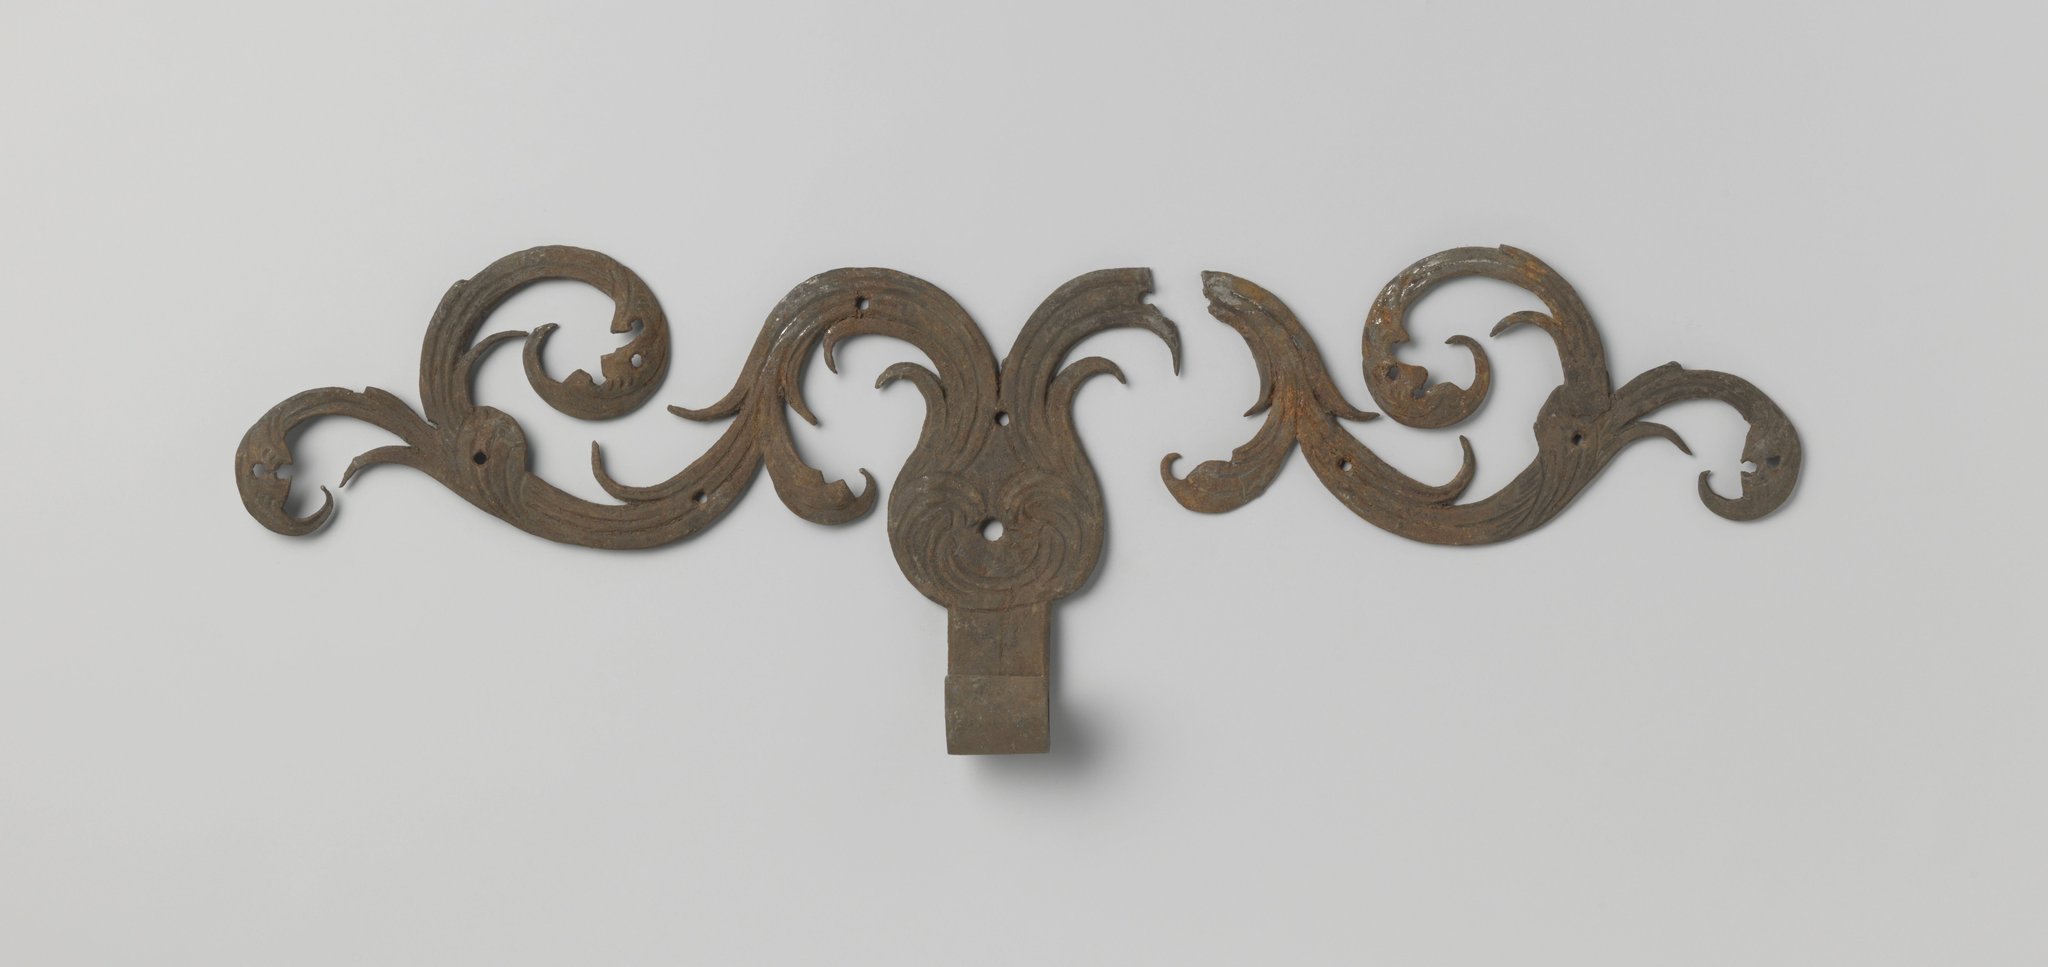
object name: hengsel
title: Hengsel van vertind ijzer met bladmotieven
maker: Anonymous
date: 1600-1800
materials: iron, tin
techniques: metalworking, tinning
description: Hengsel van vertind ijzer. Onderaan een grote, ronde opening van een scharnier met daaraan een ronde aanzet. Van daaruit ontspringen twee symmetrische bladmotieven, die naar het einde toe splitsen.